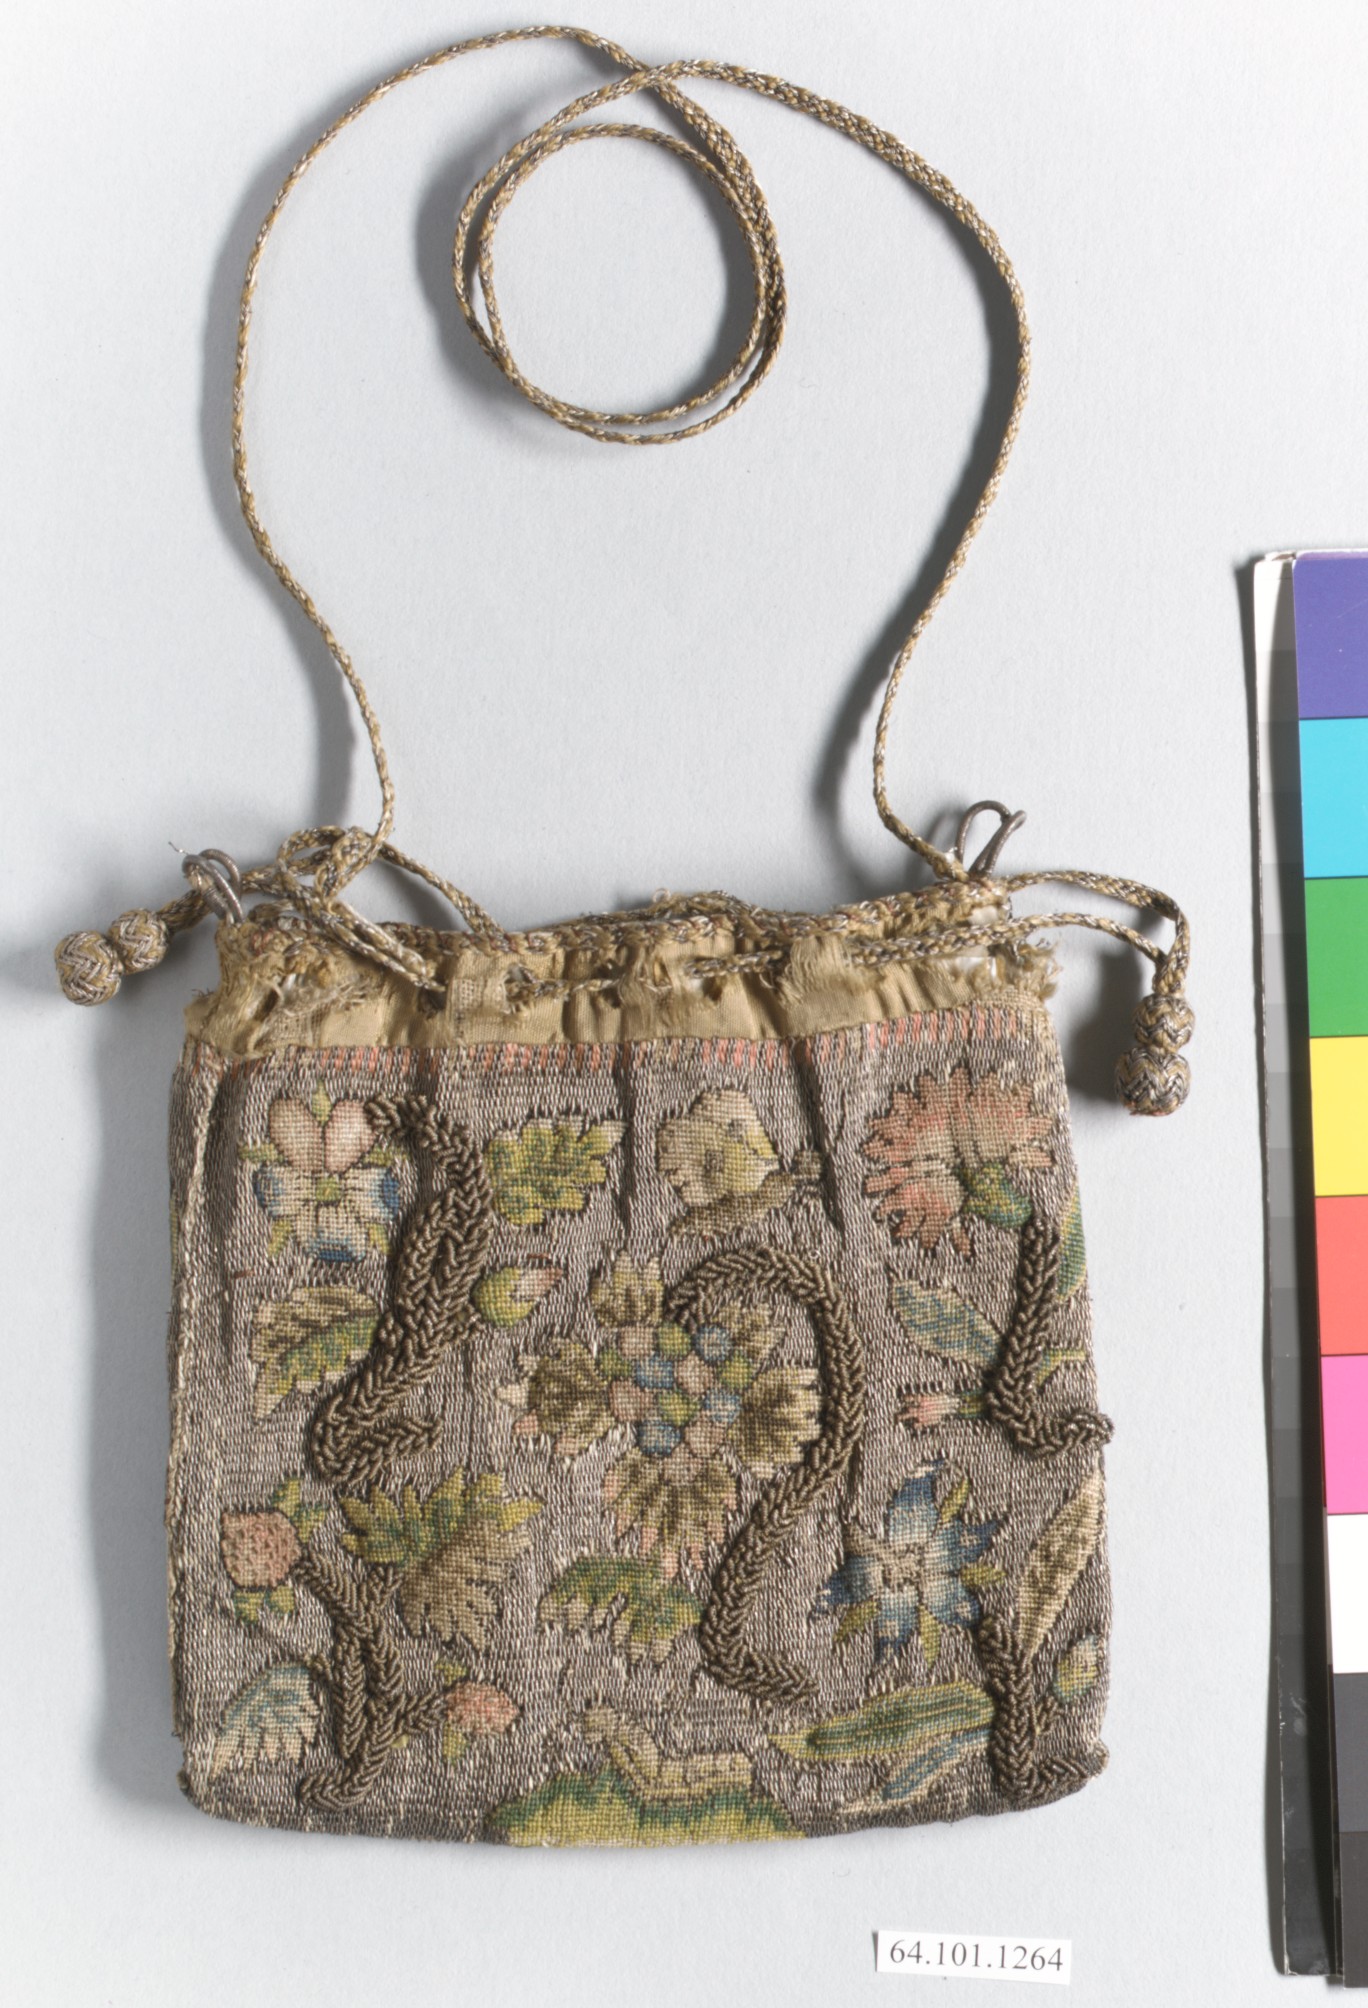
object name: purse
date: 1601-1625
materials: canvas, metal thread, silk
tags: flowers